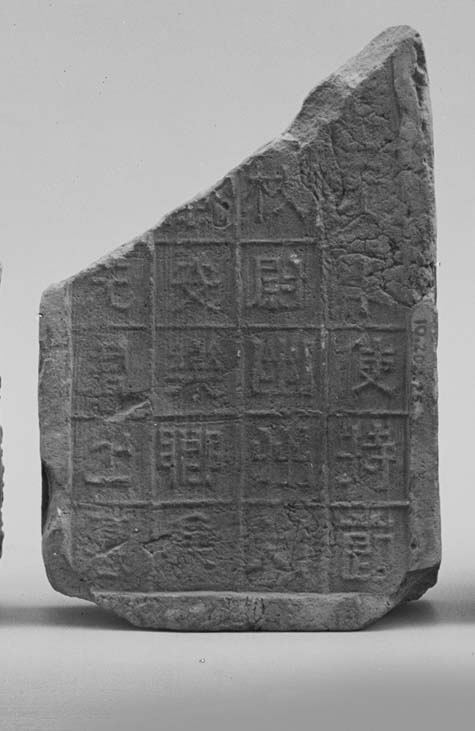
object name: tile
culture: chinese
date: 221 BCE-220 CE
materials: earthenware